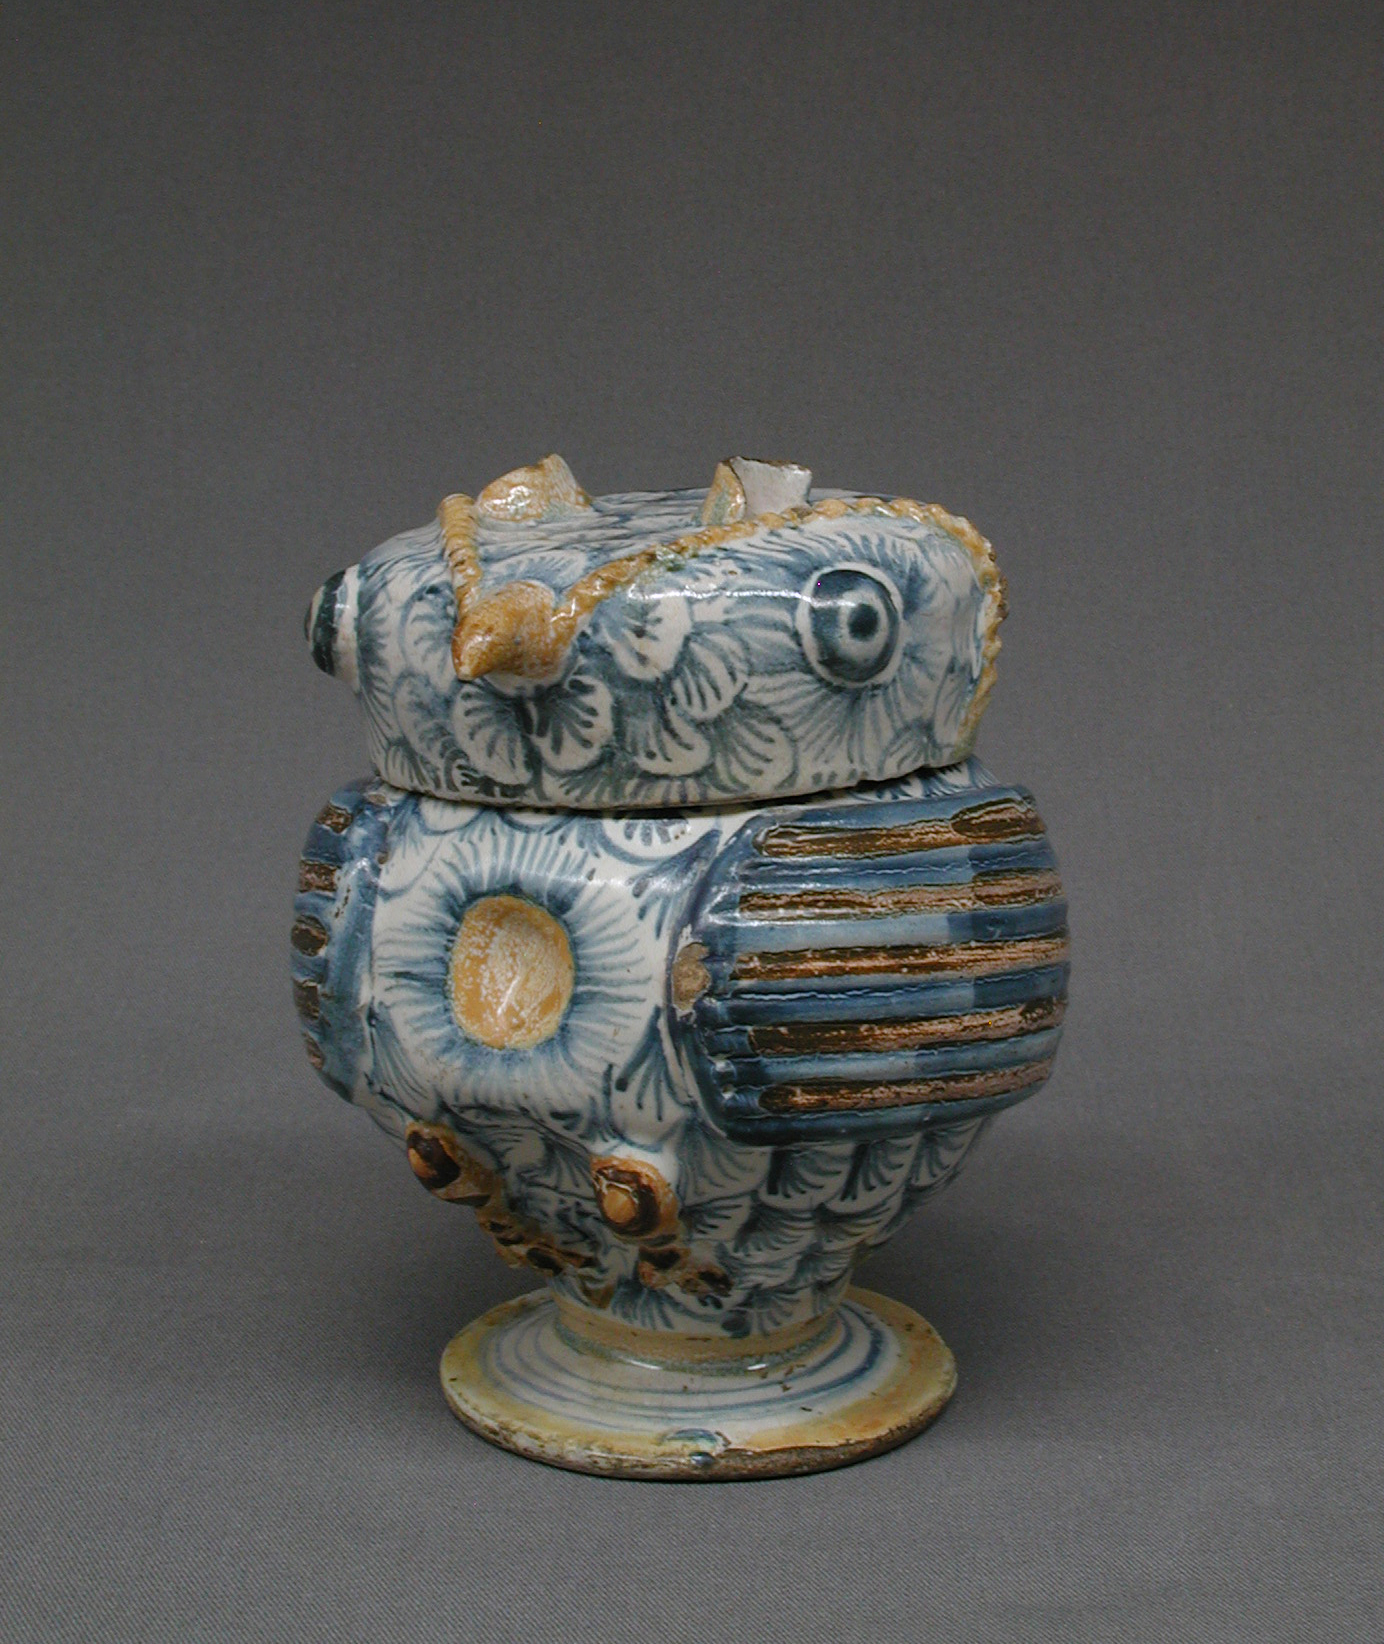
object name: tankard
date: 1651-1700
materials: earthenware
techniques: glazing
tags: owls